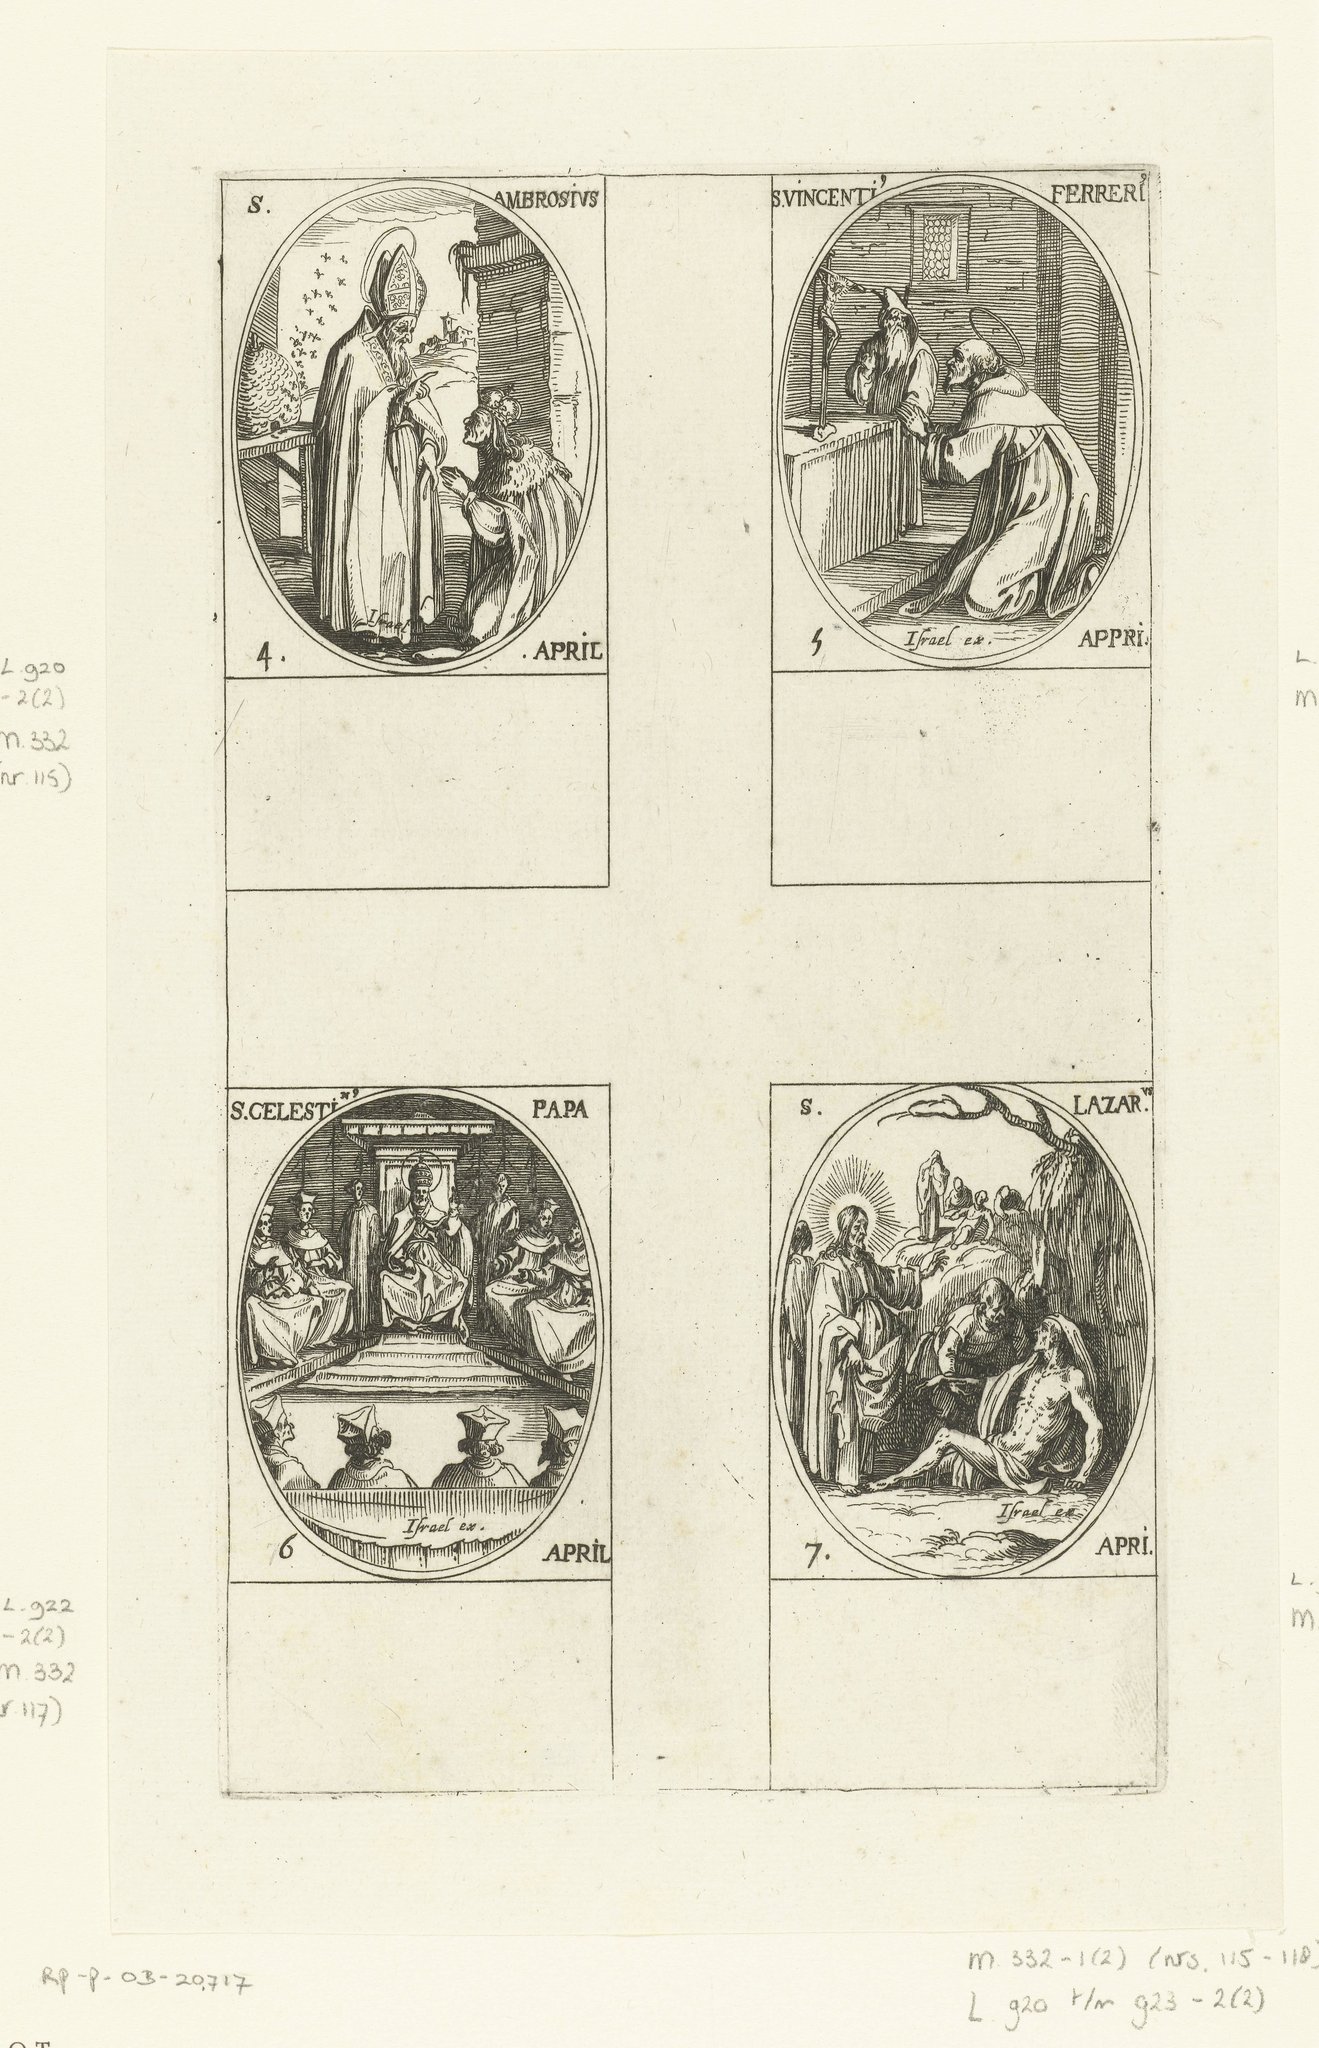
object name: print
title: Heilige Ambrosius van Milaan, Heilige Vincentius Ferrerius, Heilige Coelestinus I, Heilige Lazarus van Betanië (4-7 april)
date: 1632-1636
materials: paper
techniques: etching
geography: paris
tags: the raising of lazarus ('lazarus, come out'), the brother of st. martha and st. mary magdalene, lazarus of bethany, bishop of marseilles; possible attributes: bishop's garment, book, the dominican friar vincent ferrer of valencia (or vannes); possible attributes: book, baptismal font, cardinal's hat at feet, flames, flaming sword, ihs monogram, lily, sun, trumpet of the last judgement, male saints (with name), ambrose, bishop of milan; possible attributes: beehive, cradle with baby, three-knotted scourge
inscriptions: collector's mark: Lugt 240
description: Blad met vier ovale voorstellingen, elk met opschrift en datum in het Latijn: linksboven de Heilige Ambrosius die, staand voor een bijenkorf, een koning toespreekt, rechtsboven de Heilige Vincentius knielend voor een crucifix, linksonder de Heilige Coelestinus als paus op een troon, rechtsonder de Heilige Lazarus die door Christus tot leven wordt gewekt. Deze prent is onderdeel van een serie prenten met voorstellingen van de heiligen en de christelijke feestdagen van het jaar. Er zijn steeds vier scènes van één plaat op één blad gedrukt. Inclusief bijbehorend titelblad en frontispice gaat het in totaal om 124 platen (490 voorstellingen). De drie platen met de laatste 12 scènes (de veranderlijke christelijke feestdagen) zijn in de derde staat versneden tot 12 kleine plaatjes, en met een apart titelblad uitgegeven.